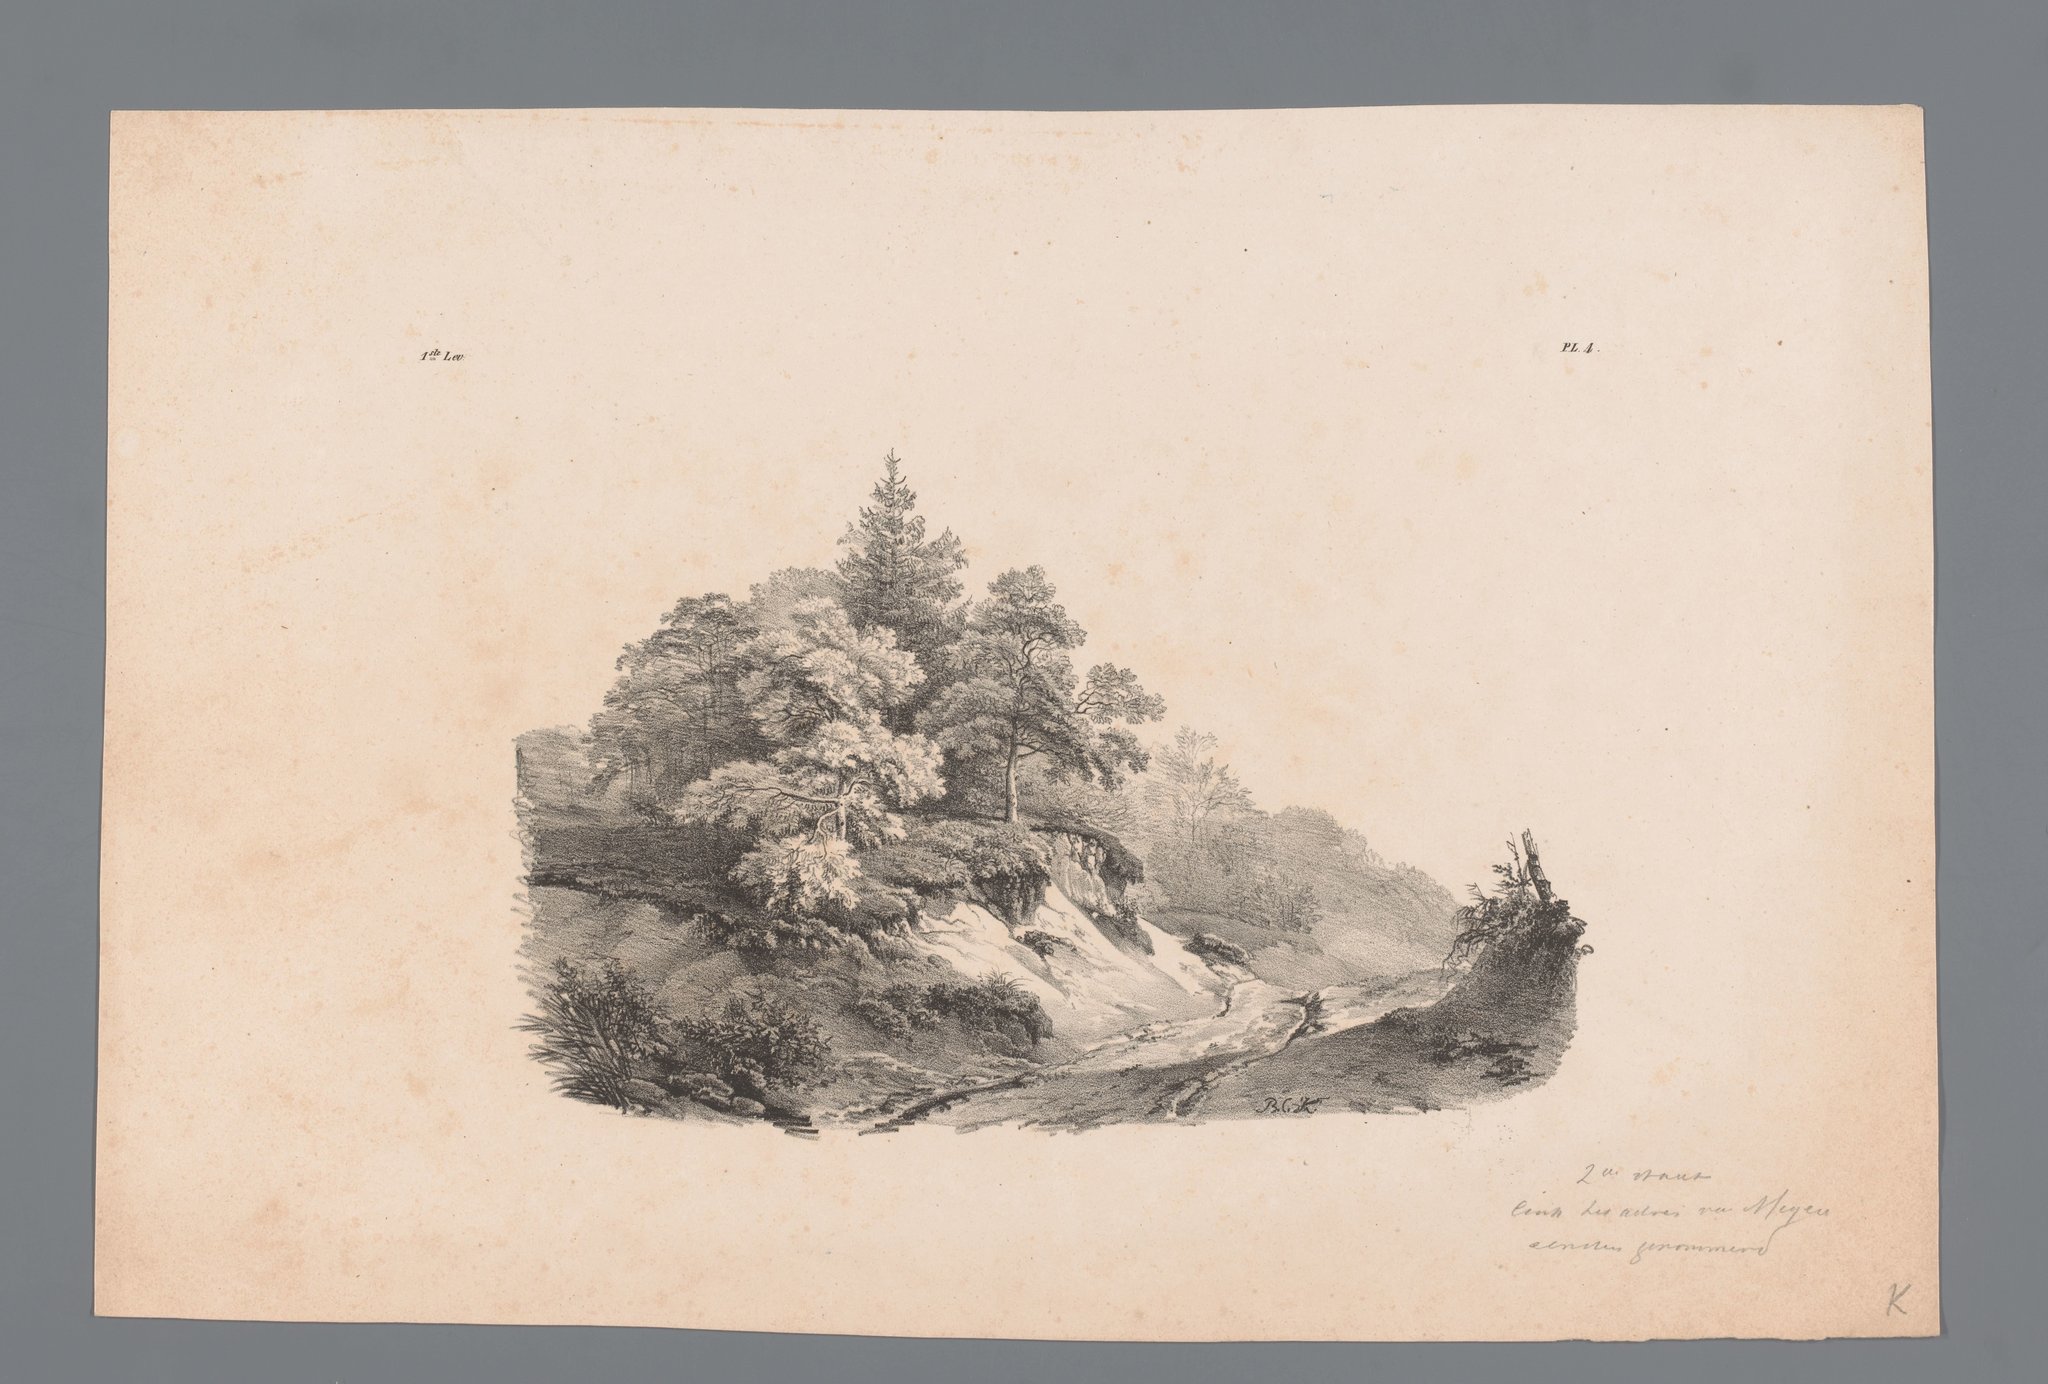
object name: print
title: Zandpad door het bos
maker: barend cornelis koekkoek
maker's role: draughtsman, painter, print maker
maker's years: 1803-1862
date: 1829-1844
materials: paper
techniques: lithograph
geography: amsterdam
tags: forest path or lane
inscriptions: collector's mark: Lugt 2228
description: In 1829 en 1830 gaf Koekkoek, samen met Daiwaille, zes cahiers uit met ieder zes prenten getiteld Landschapstudiën. Deze werden gebruikt in het tekenonderwijs. Vijftien jaar later werd deze reeks, in een andere samenstelling nogmaals uitgegeven door Meyer en Comp in Amsterdam. Zie: De Bruyn Kops, 1963.